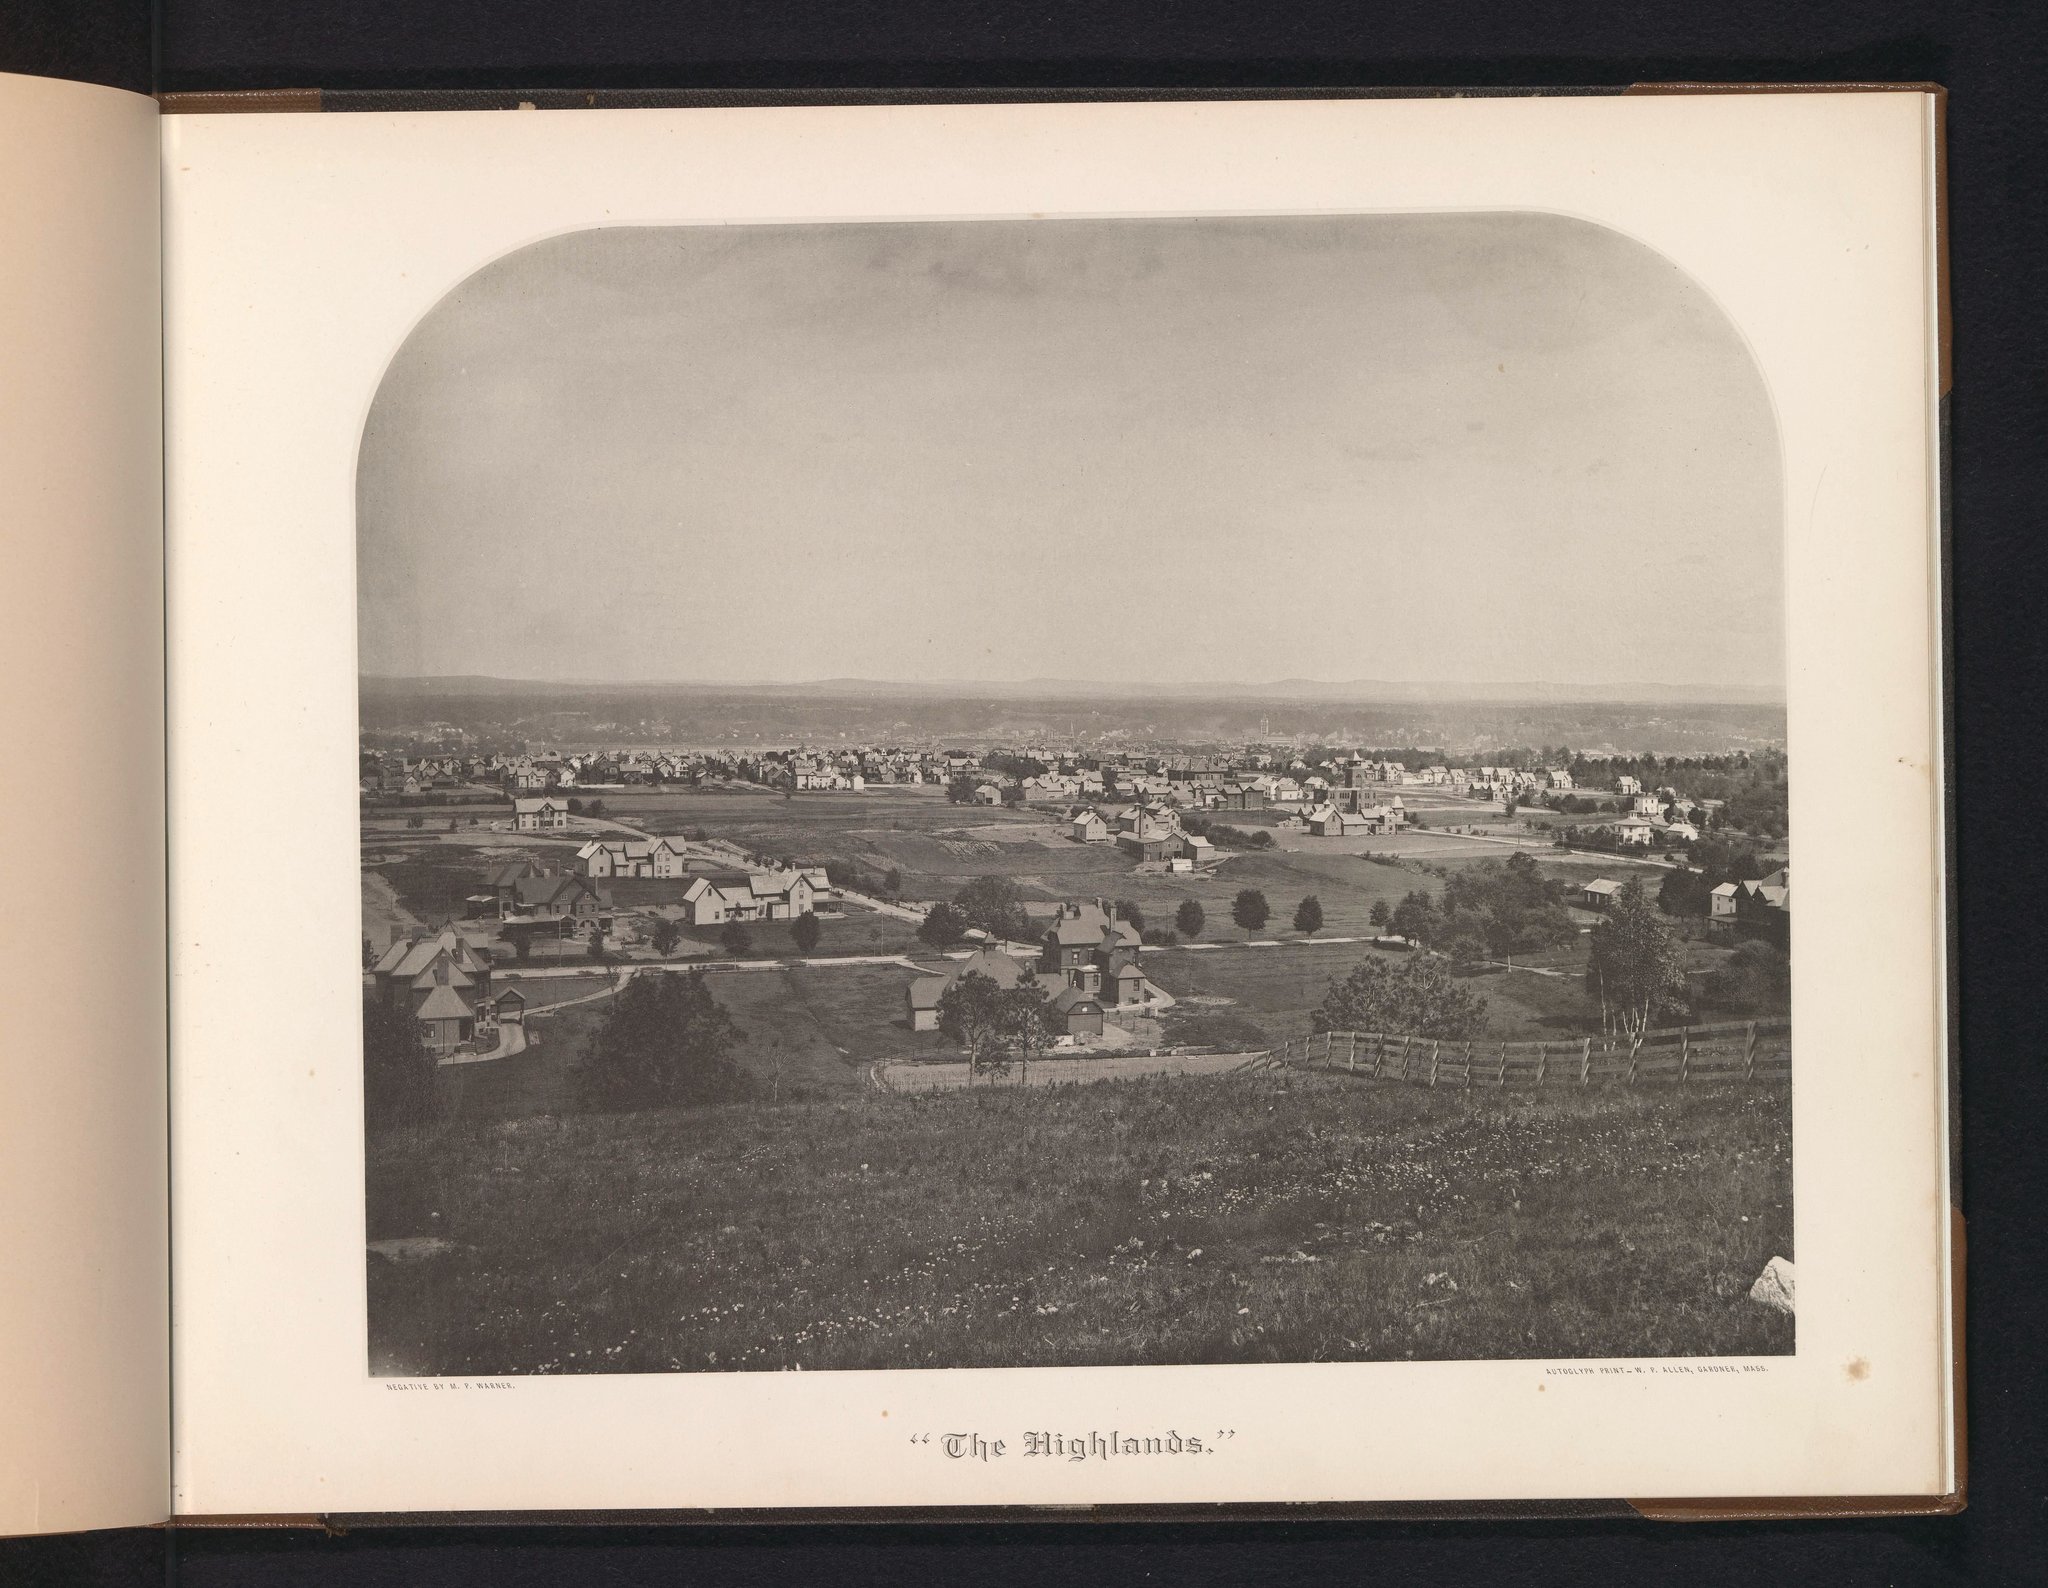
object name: photomechanical print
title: "The Highlands"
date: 1883-1888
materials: paper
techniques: photograph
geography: massachusetts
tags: city-view in general; 'veduta'